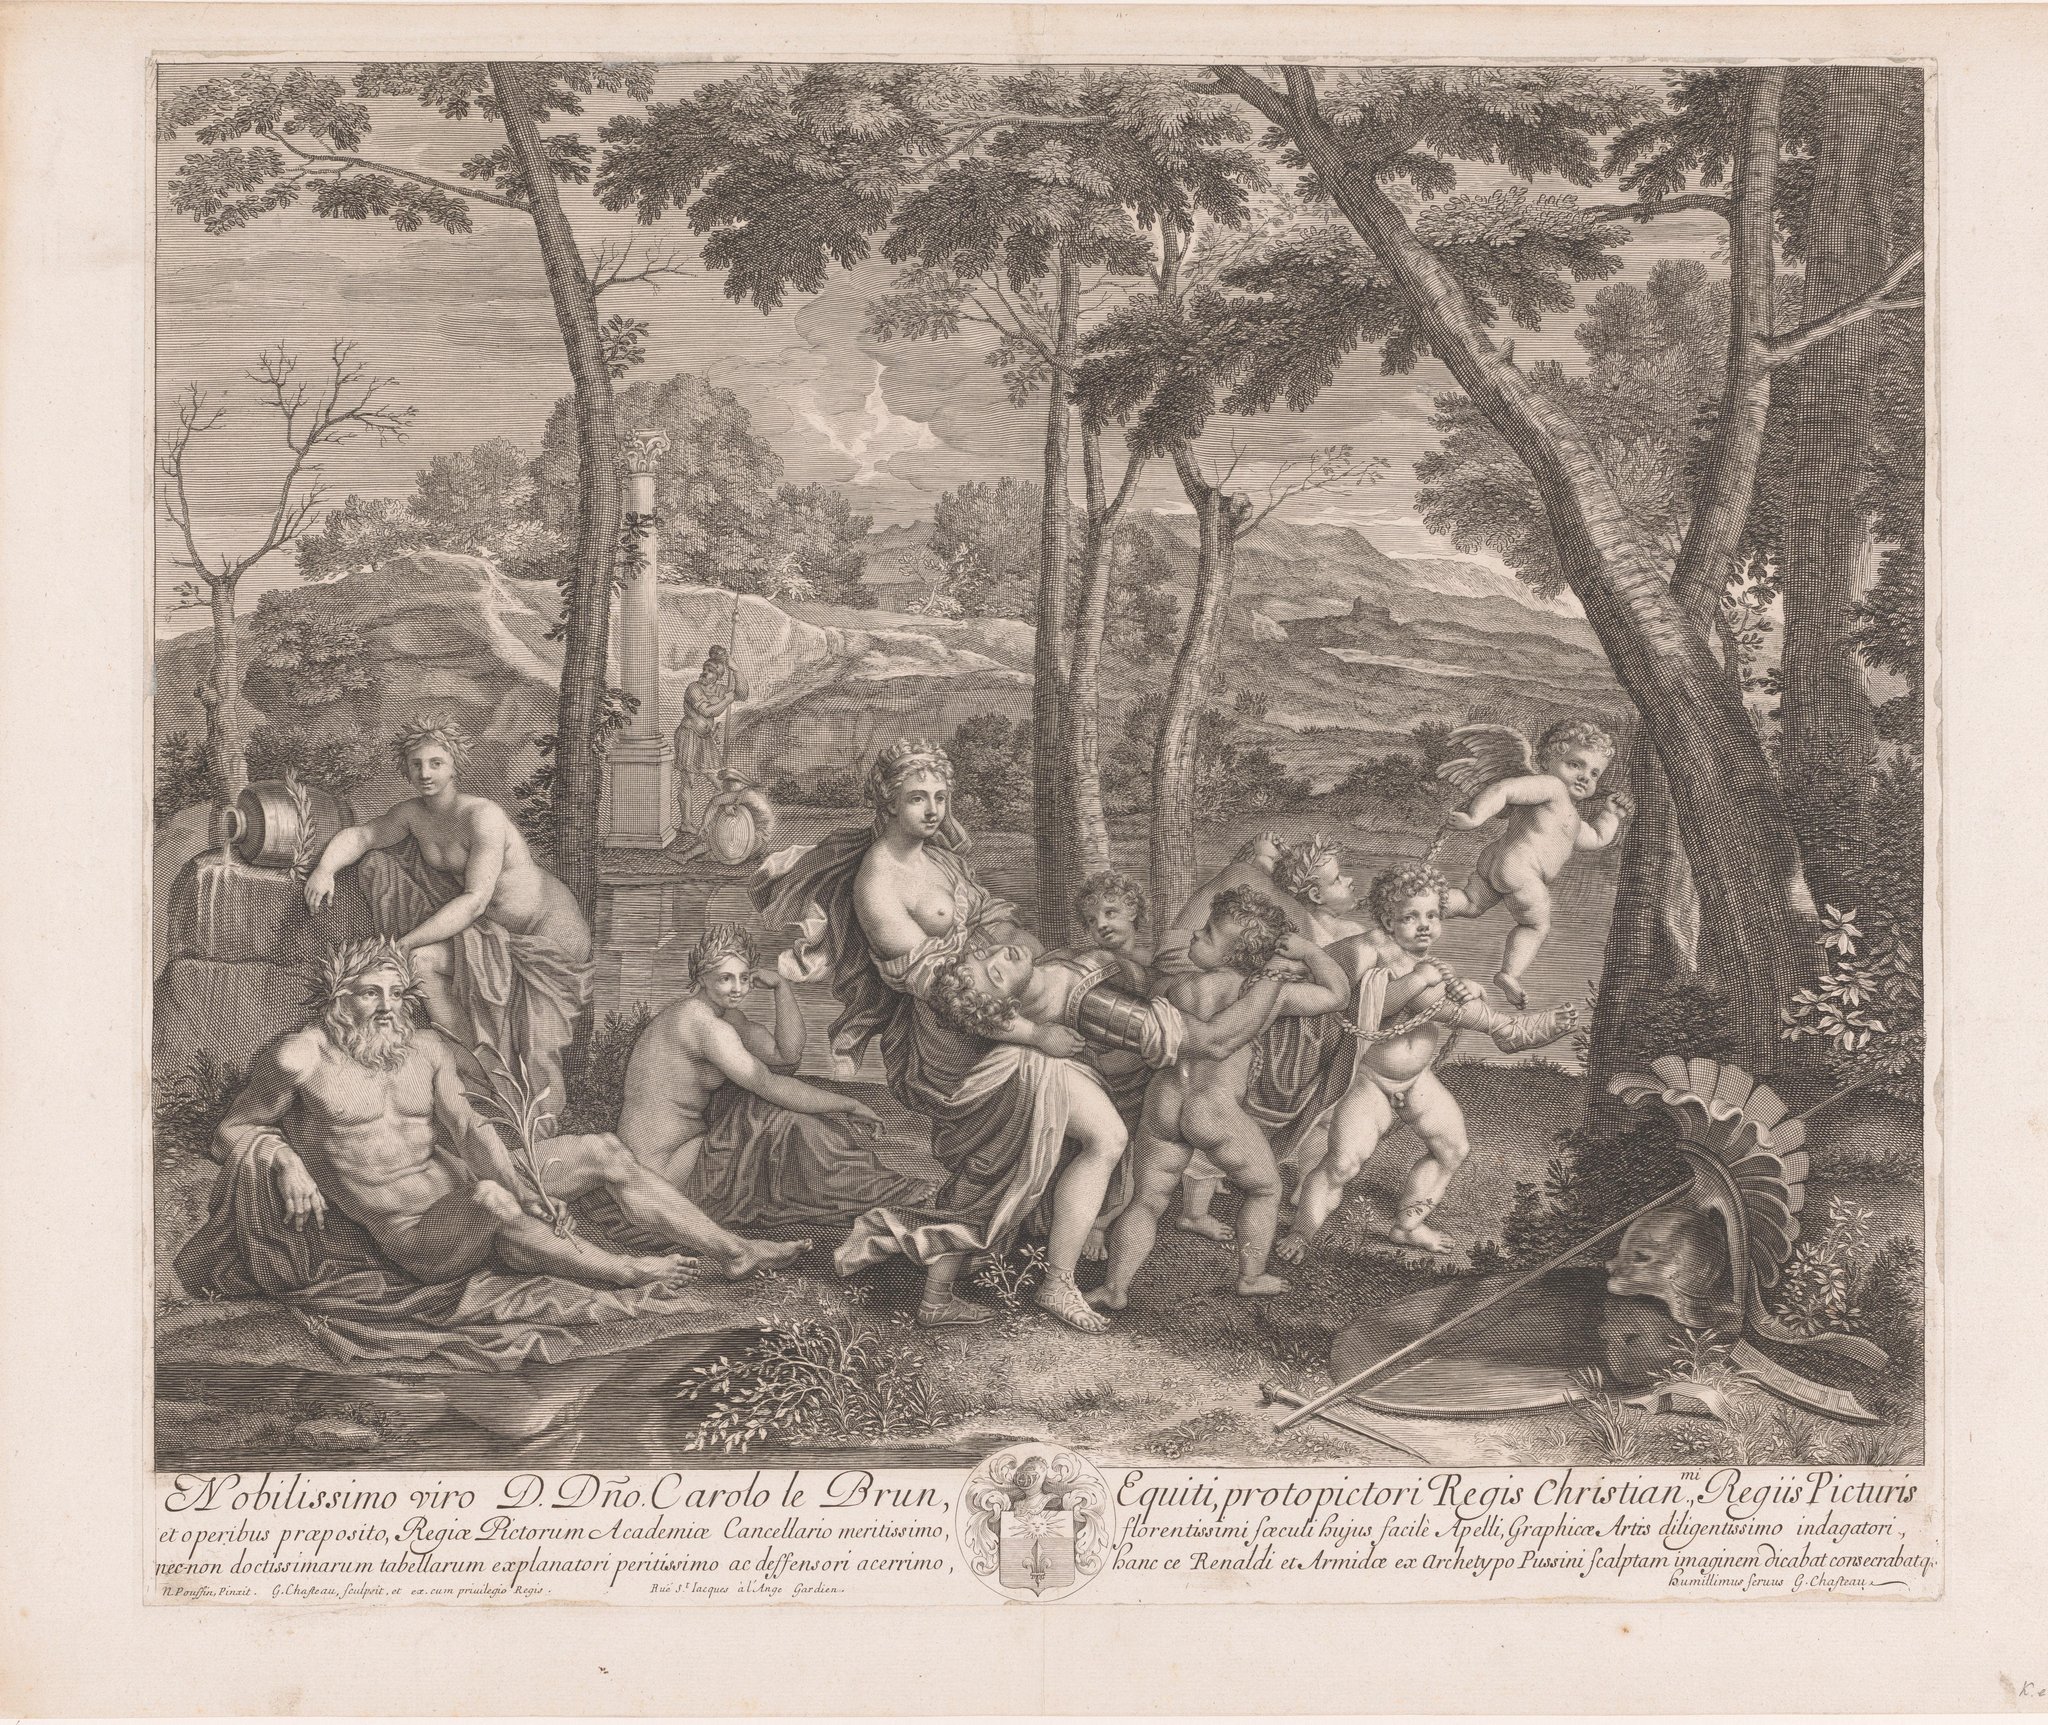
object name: print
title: Rinaldo en Armida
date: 1645-1683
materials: paper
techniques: engraving, etching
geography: france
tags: rinaldo, armida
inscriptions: collector's mark: Lugt 240, number: ‘87’